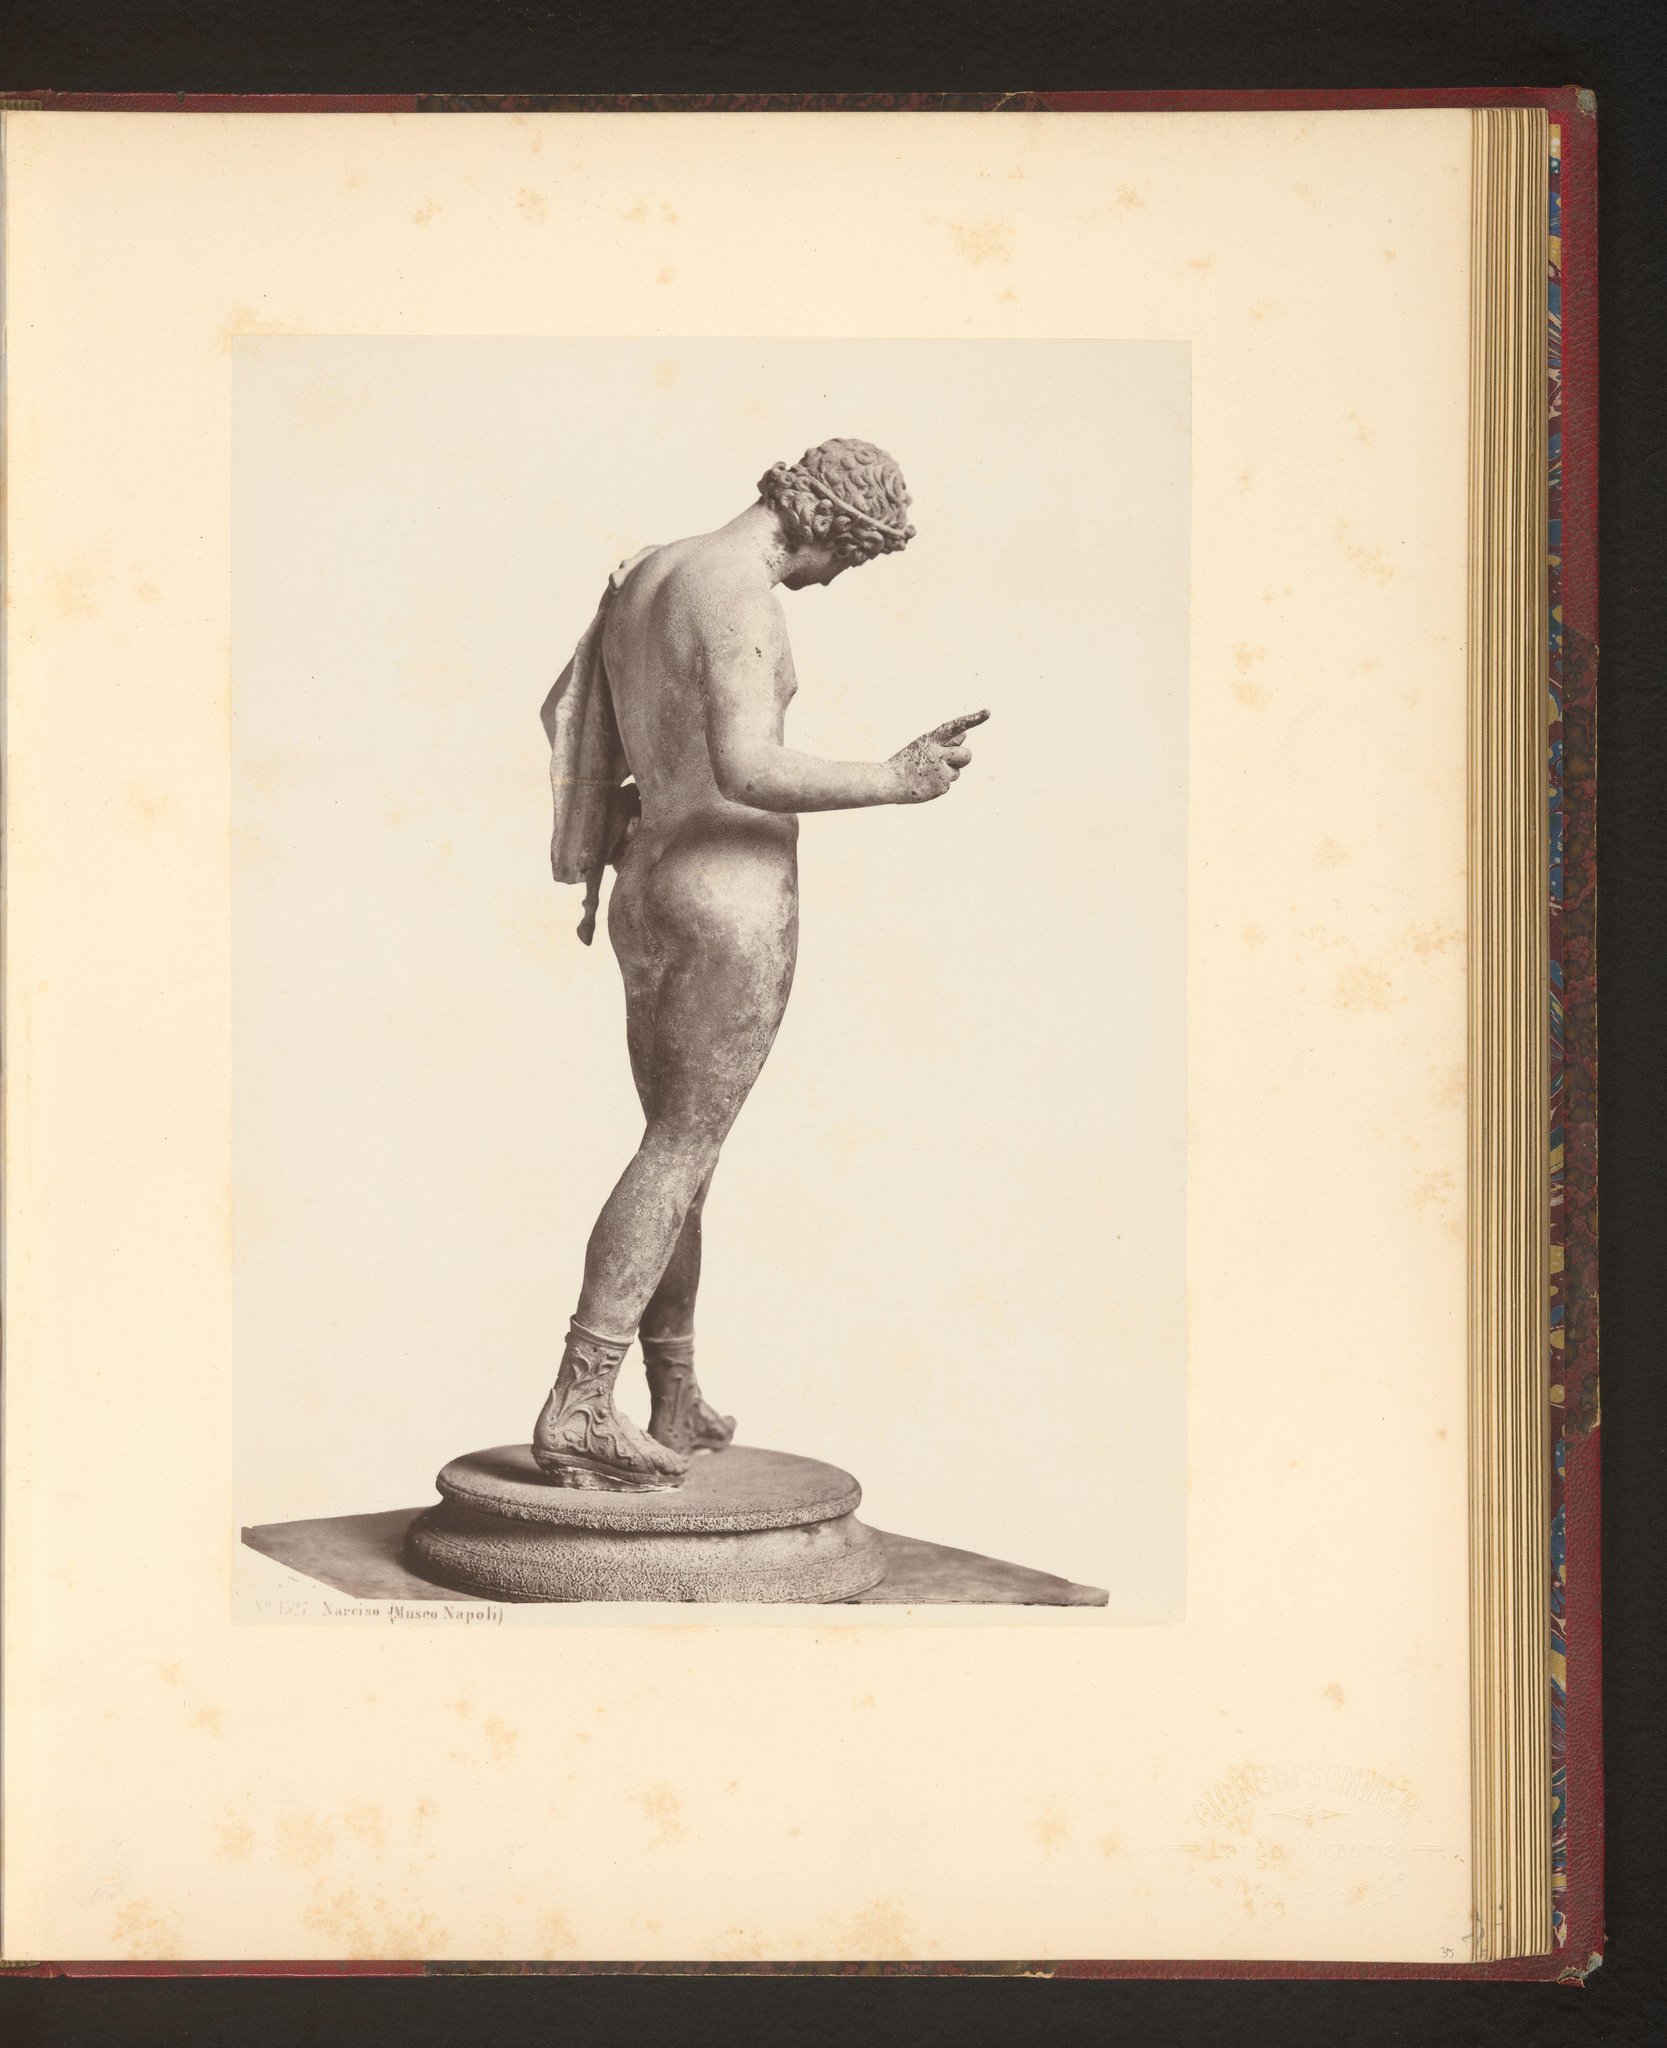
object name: photograph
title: Sculptuur van Narcissus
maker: giorgio sommer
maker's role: fotograaf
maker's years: 1834-1914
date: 1874-1879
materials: photographic support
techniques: albumen print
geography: naples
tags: (story of) narcissus, sculpture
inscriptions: workshop stamp: ‘Giorgio Sommer/ Largo Vittoria/ Napoli’, number: ‘1527’